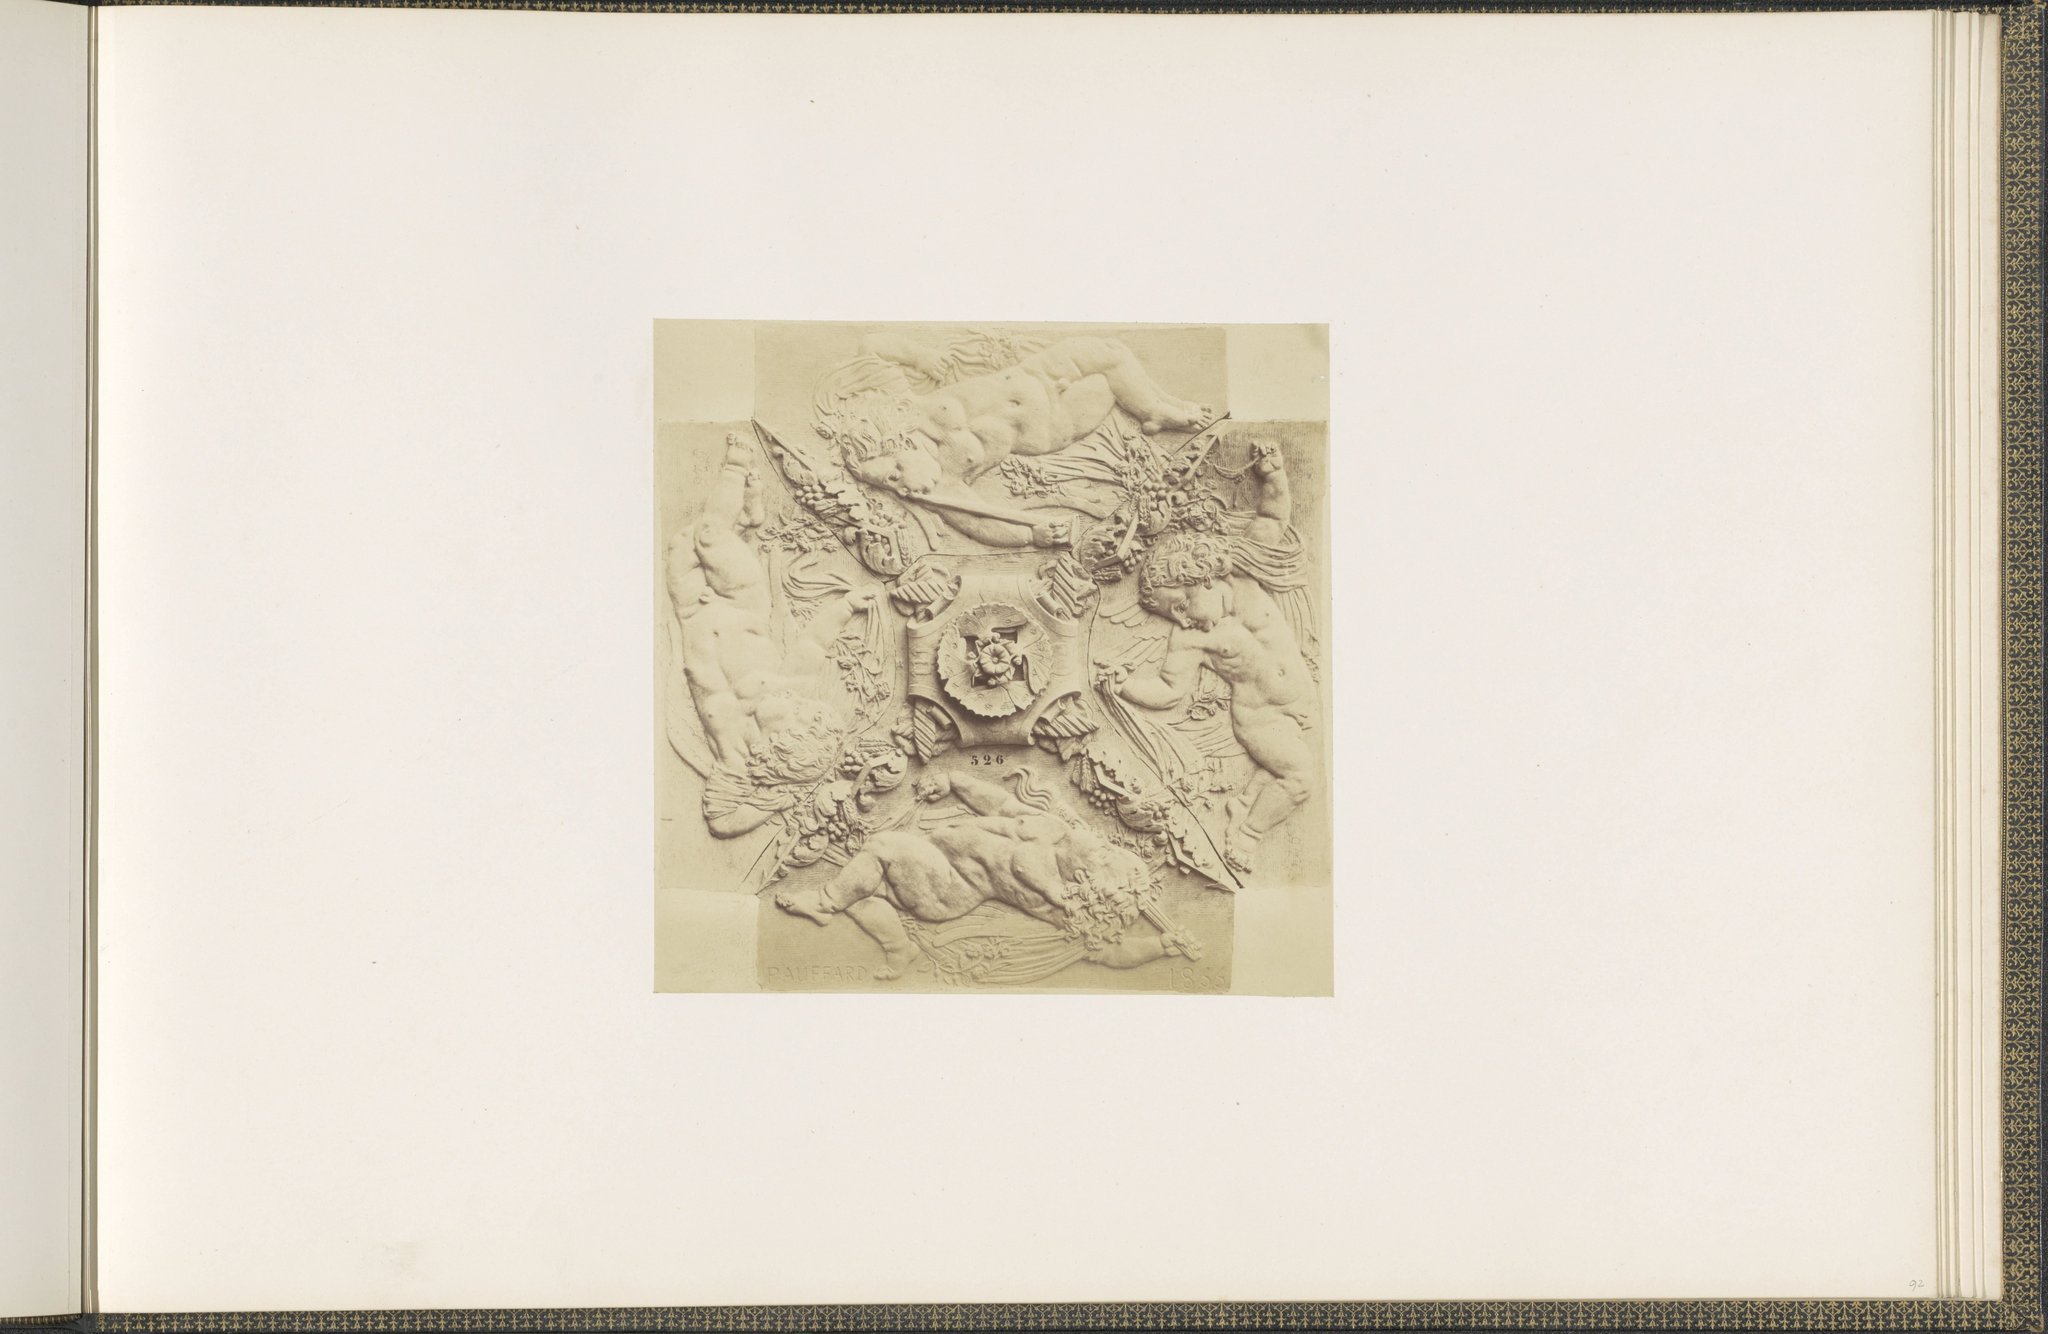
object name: album leaf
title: Gipsmodel voor een gewelfversiering van het Palais du Louvre door Auguste Pauffard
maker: édouard denis baldus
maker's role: fotograaf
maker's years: 1813-1889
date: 1855-1857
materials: paper, photographic support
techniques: salted paper print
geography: paris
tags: permanent exhibition, museum, ornamenting, decorating ~ applied arts, paris, tuileries palace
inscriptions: number: ‘526’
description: Onderdeel van Réunion des Tuileries au Louvre 1852-1857, album 4.